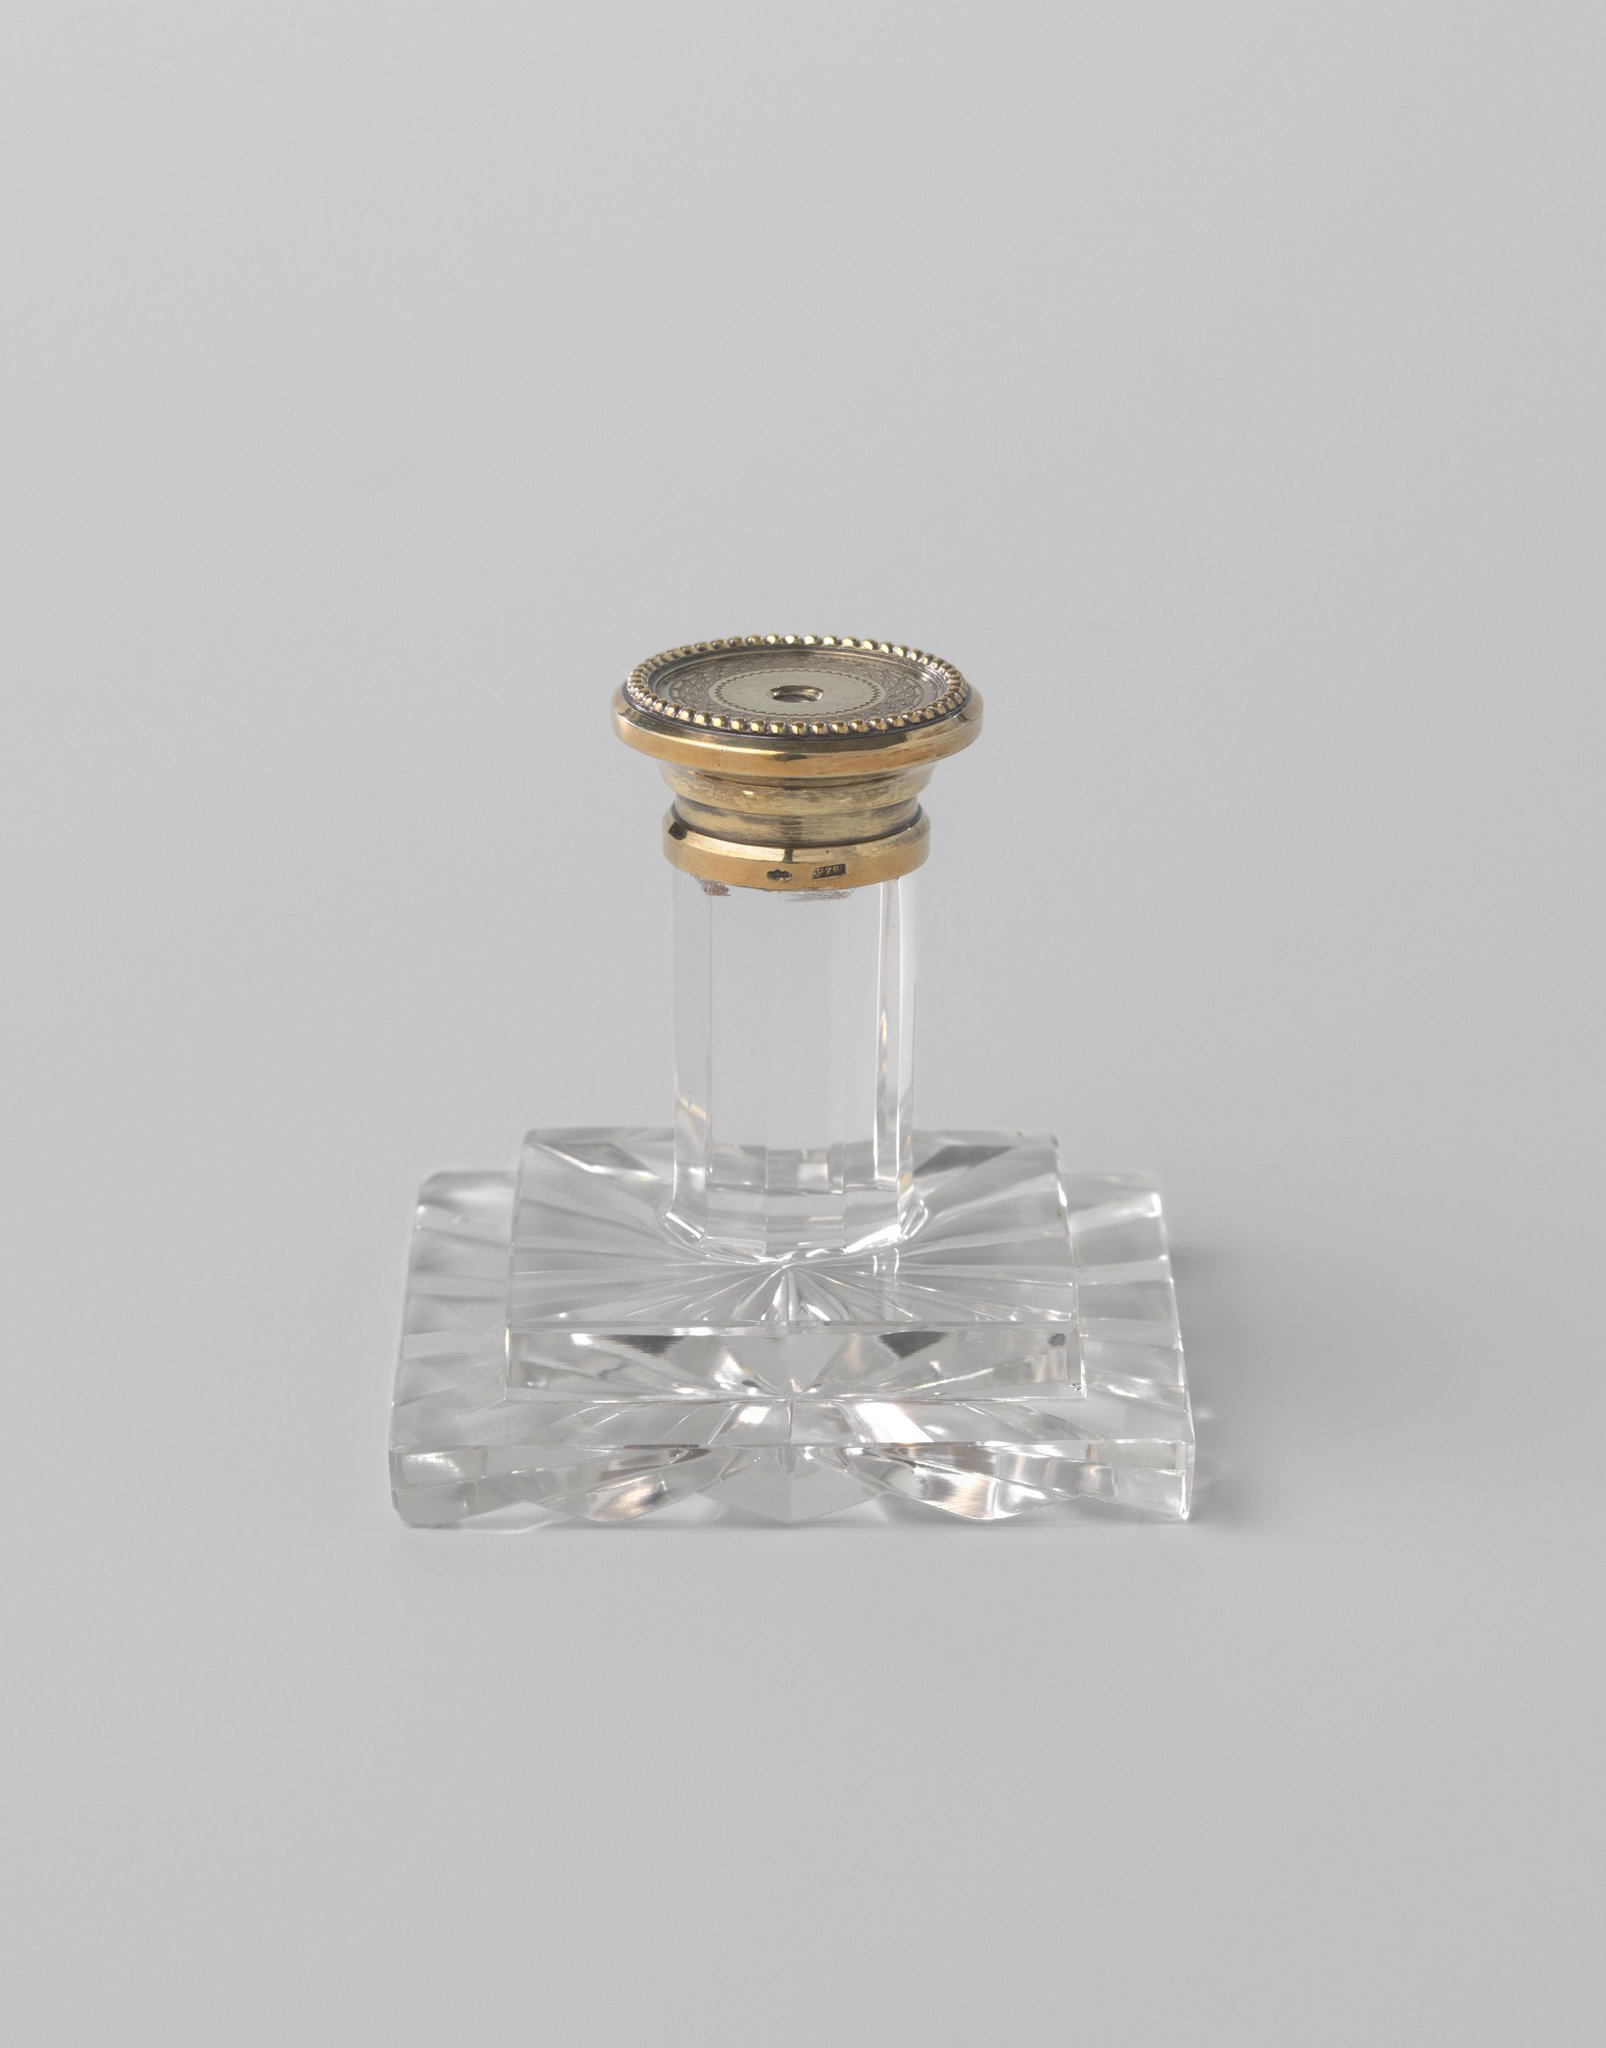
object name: kaarsenhouder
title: Kristallen voet van kaarsenhouder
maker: joseph aymé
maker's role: silversmith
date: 1942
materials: glass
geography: paris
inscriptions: maker's mark, maker's mark: ‘JA’, alloy mark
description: Niet in de kist passende kristallen voet van kaarsenhouder